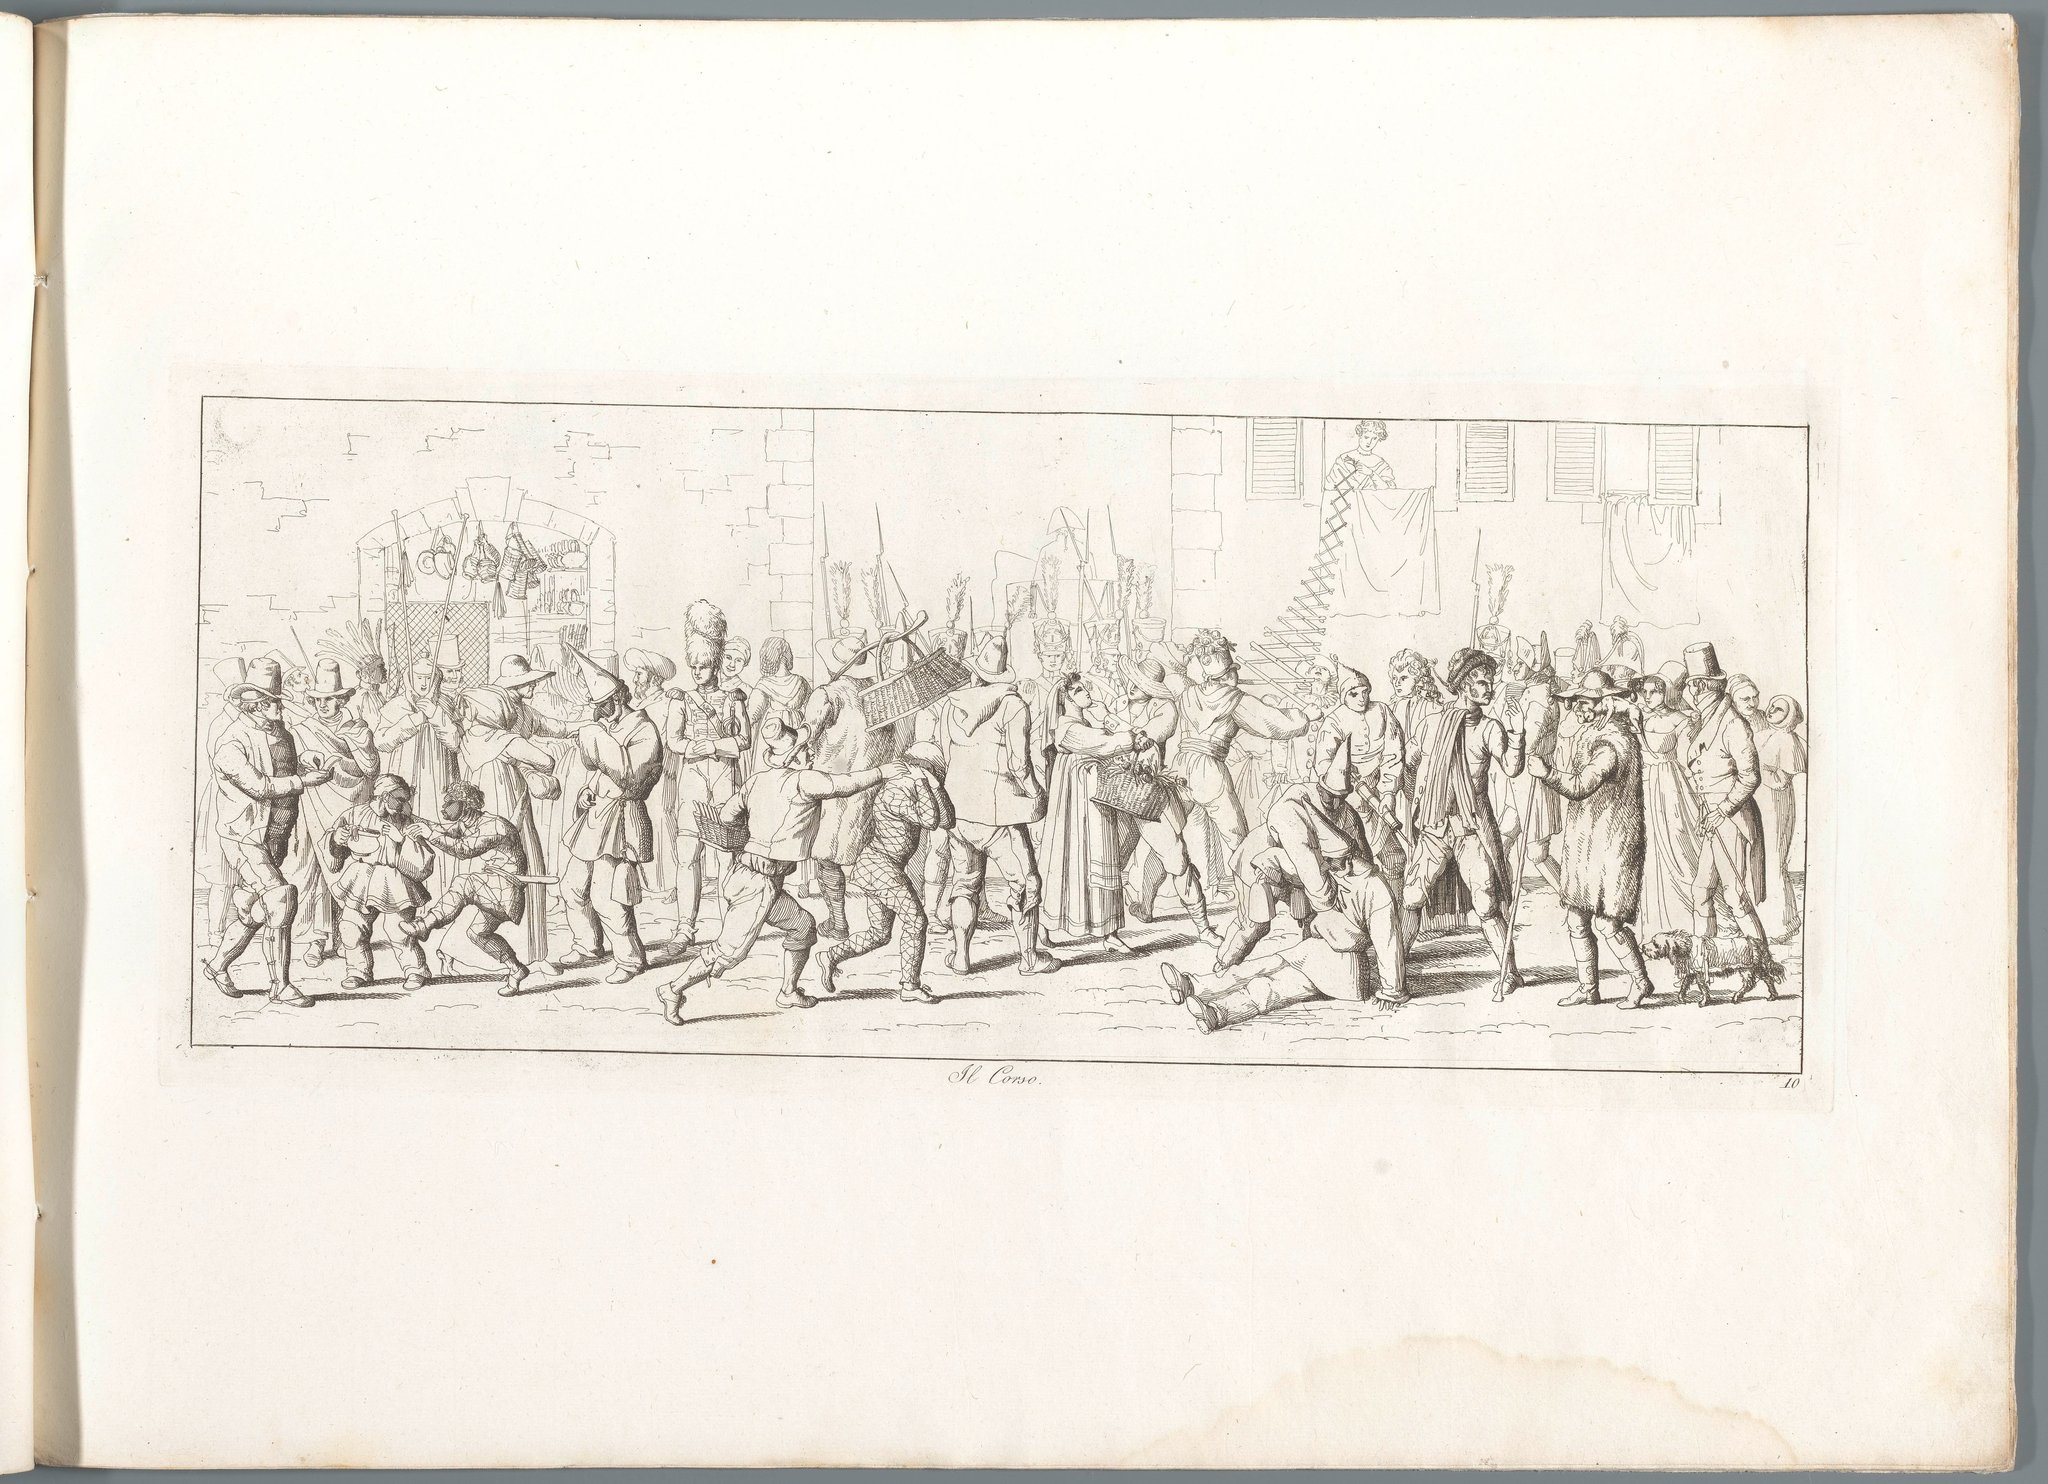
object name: print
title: Il Carnevale di Roma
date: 1820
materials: paper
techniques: etching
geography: rome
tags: carnival, shrovetide (non-liturgical celebration), rome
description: Carnavalsoptocht over de Via del Corso. Onderdeel van een prentwerk met een serie van twintig prenten over de viering van carnaval in Rome.